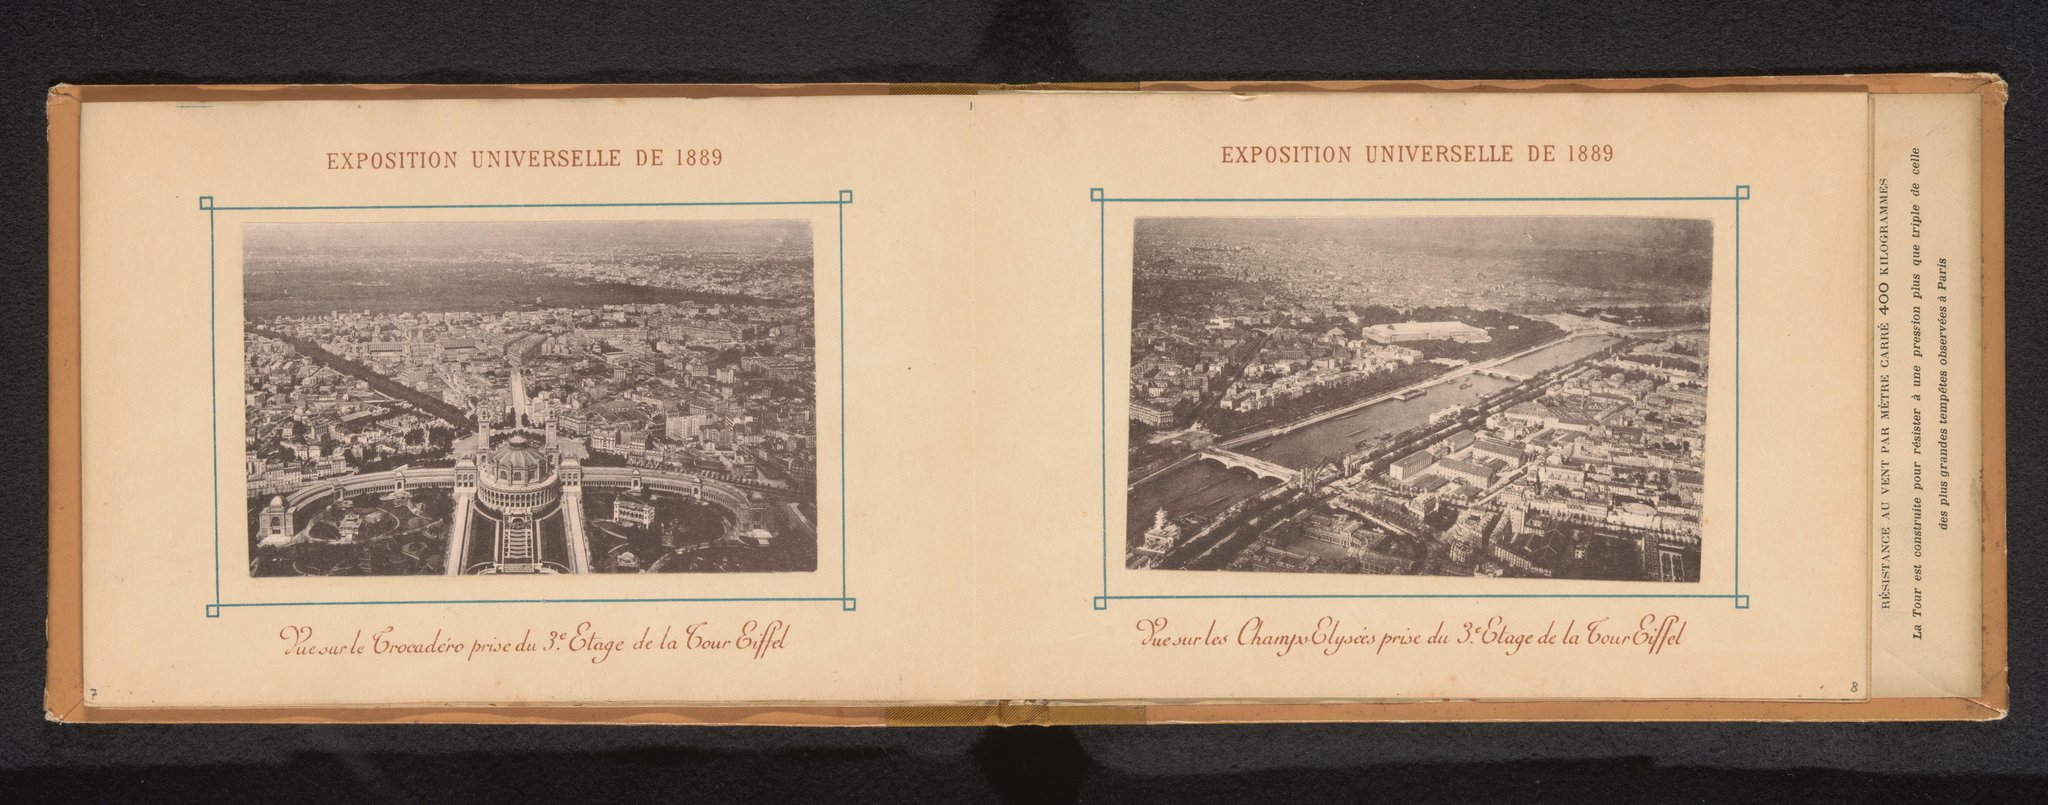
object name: photomechanical print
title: Vue sur les Champs Elysées prise du 3e Etage de la Tour Eiffel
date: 1889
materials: paper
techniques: photograph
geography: paris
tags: city-view, and landscape with man-made constructions, paris